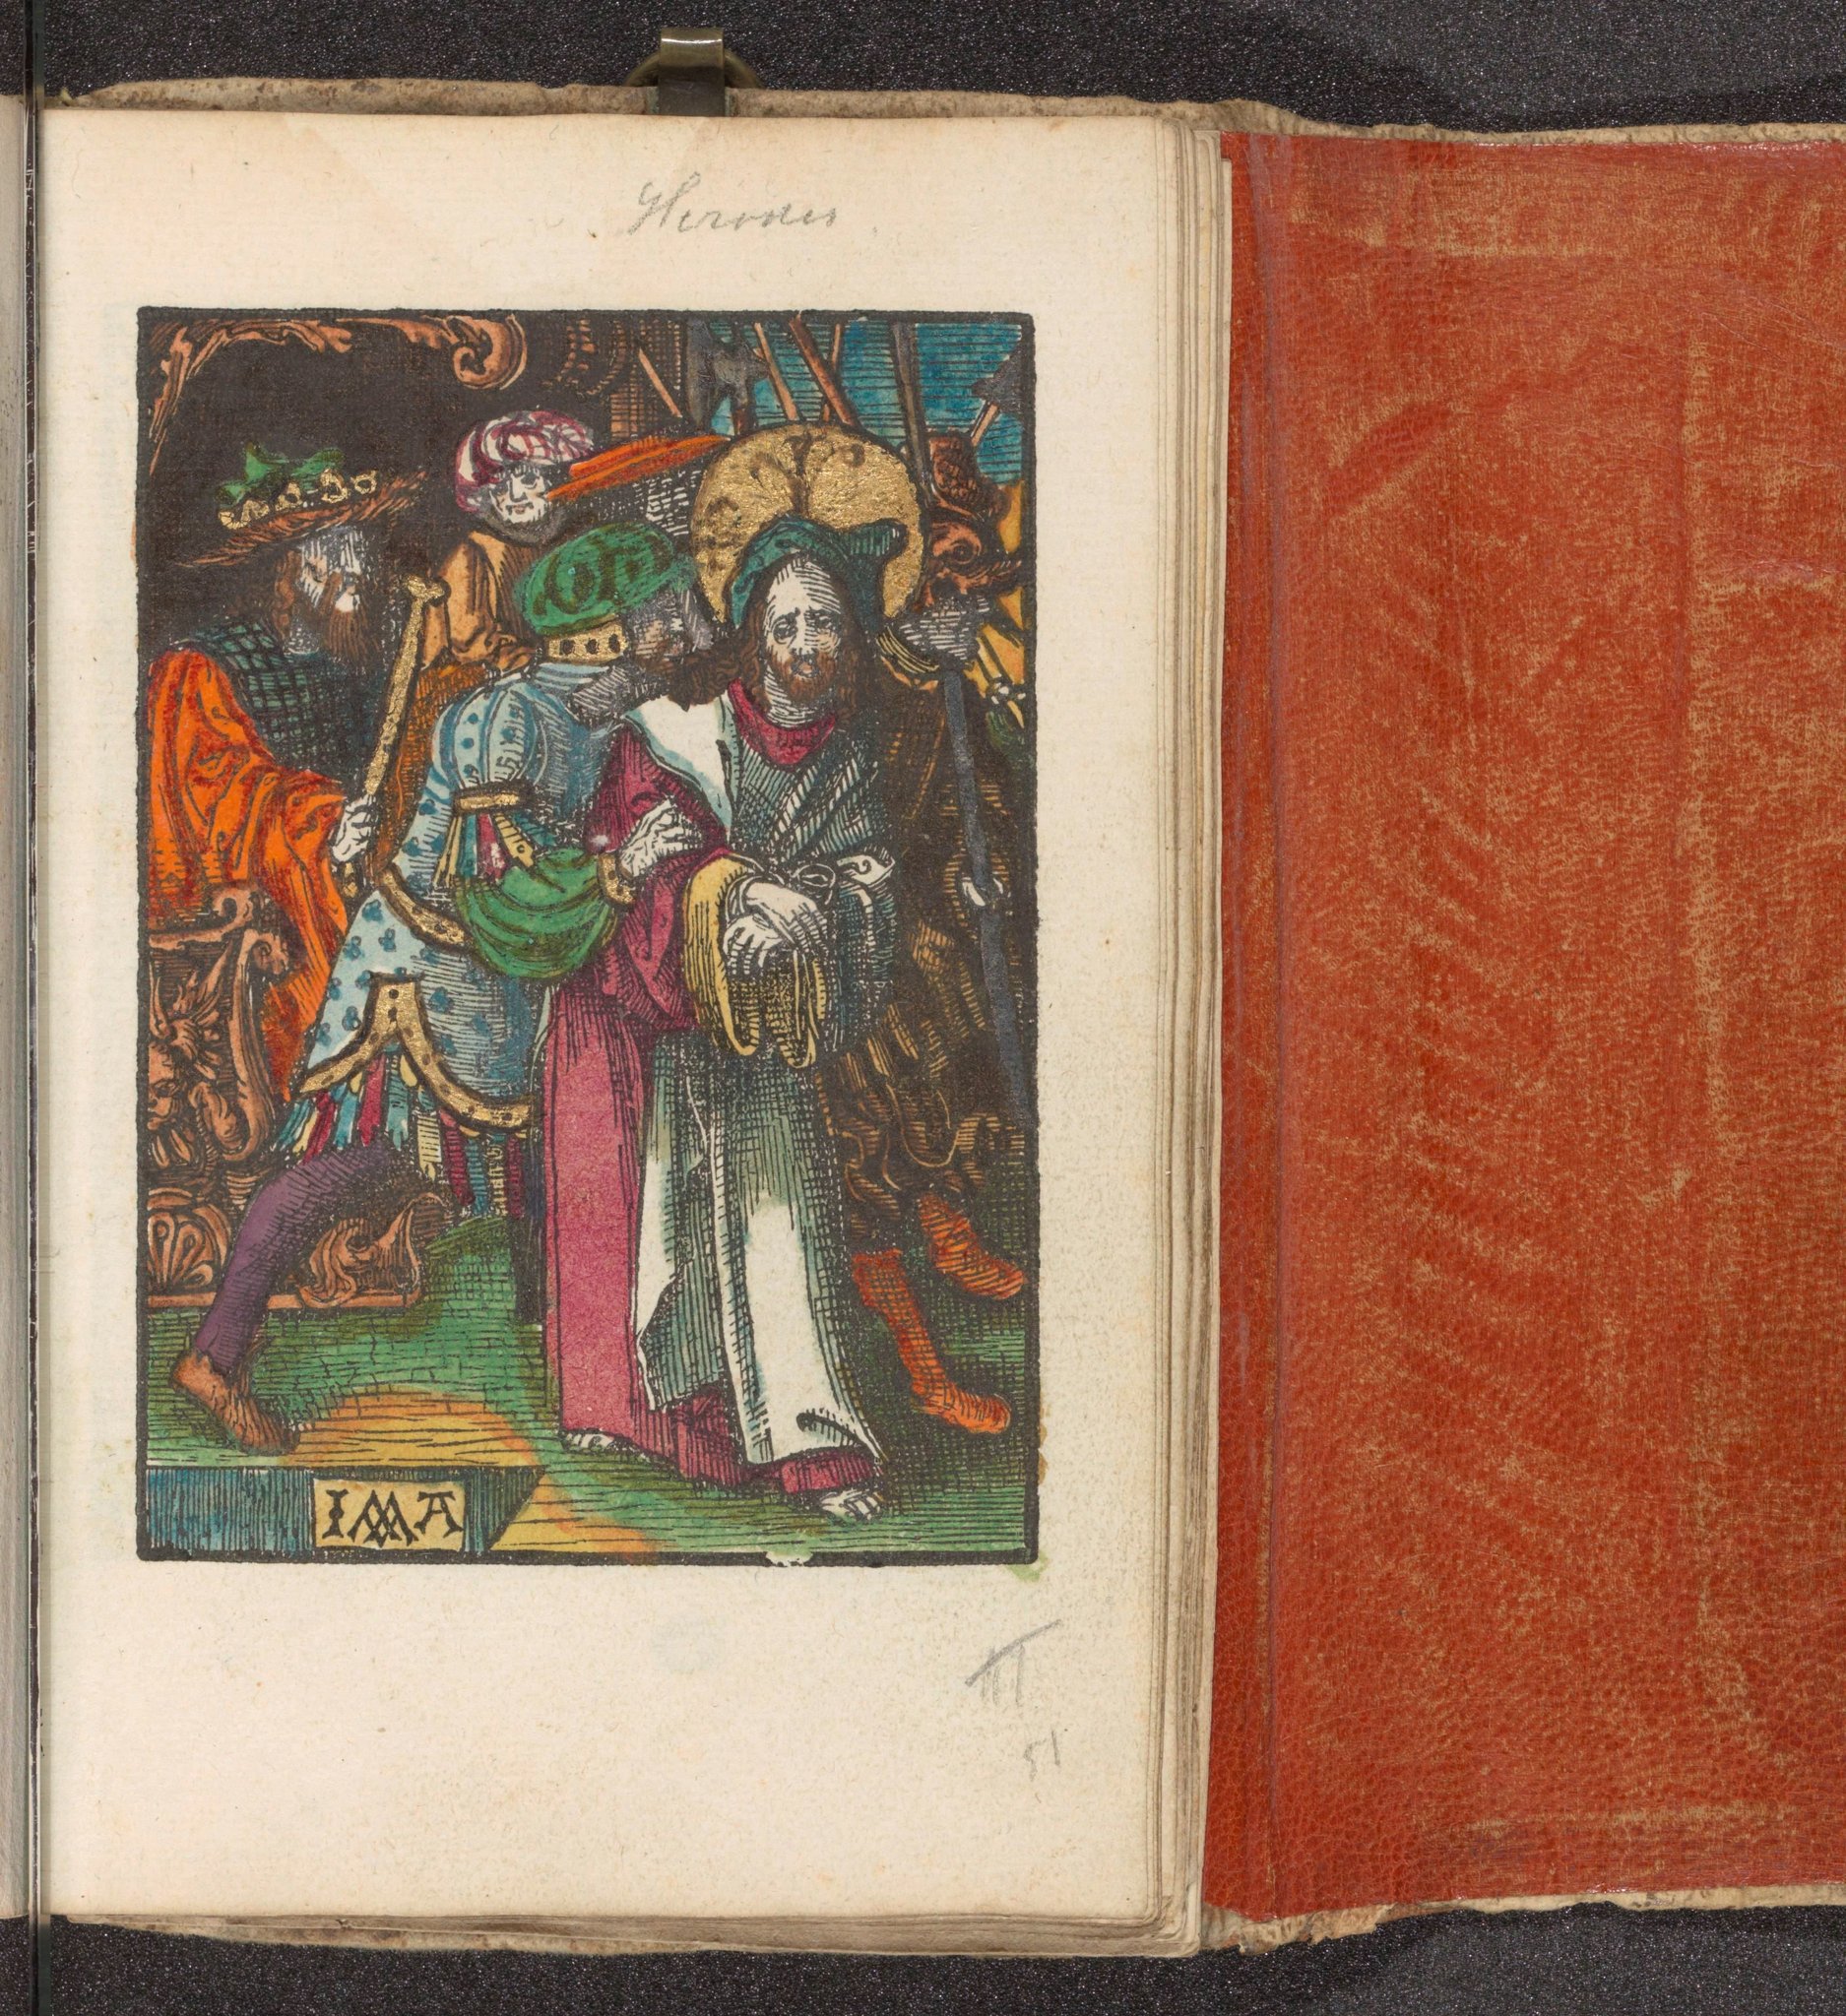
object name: album leaf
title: Stomme Passie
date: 1520-1521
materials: paper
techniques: hand coloring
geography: amsterdam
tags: book in which illustrations are essential, christ before king herod; sometimes a gorgeous robe is brought (luke 23:8-11), christ brought from one judge to another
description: Soldaten leiden Christus weg van koning Herodes. Prent maakt deel uit van een boek.